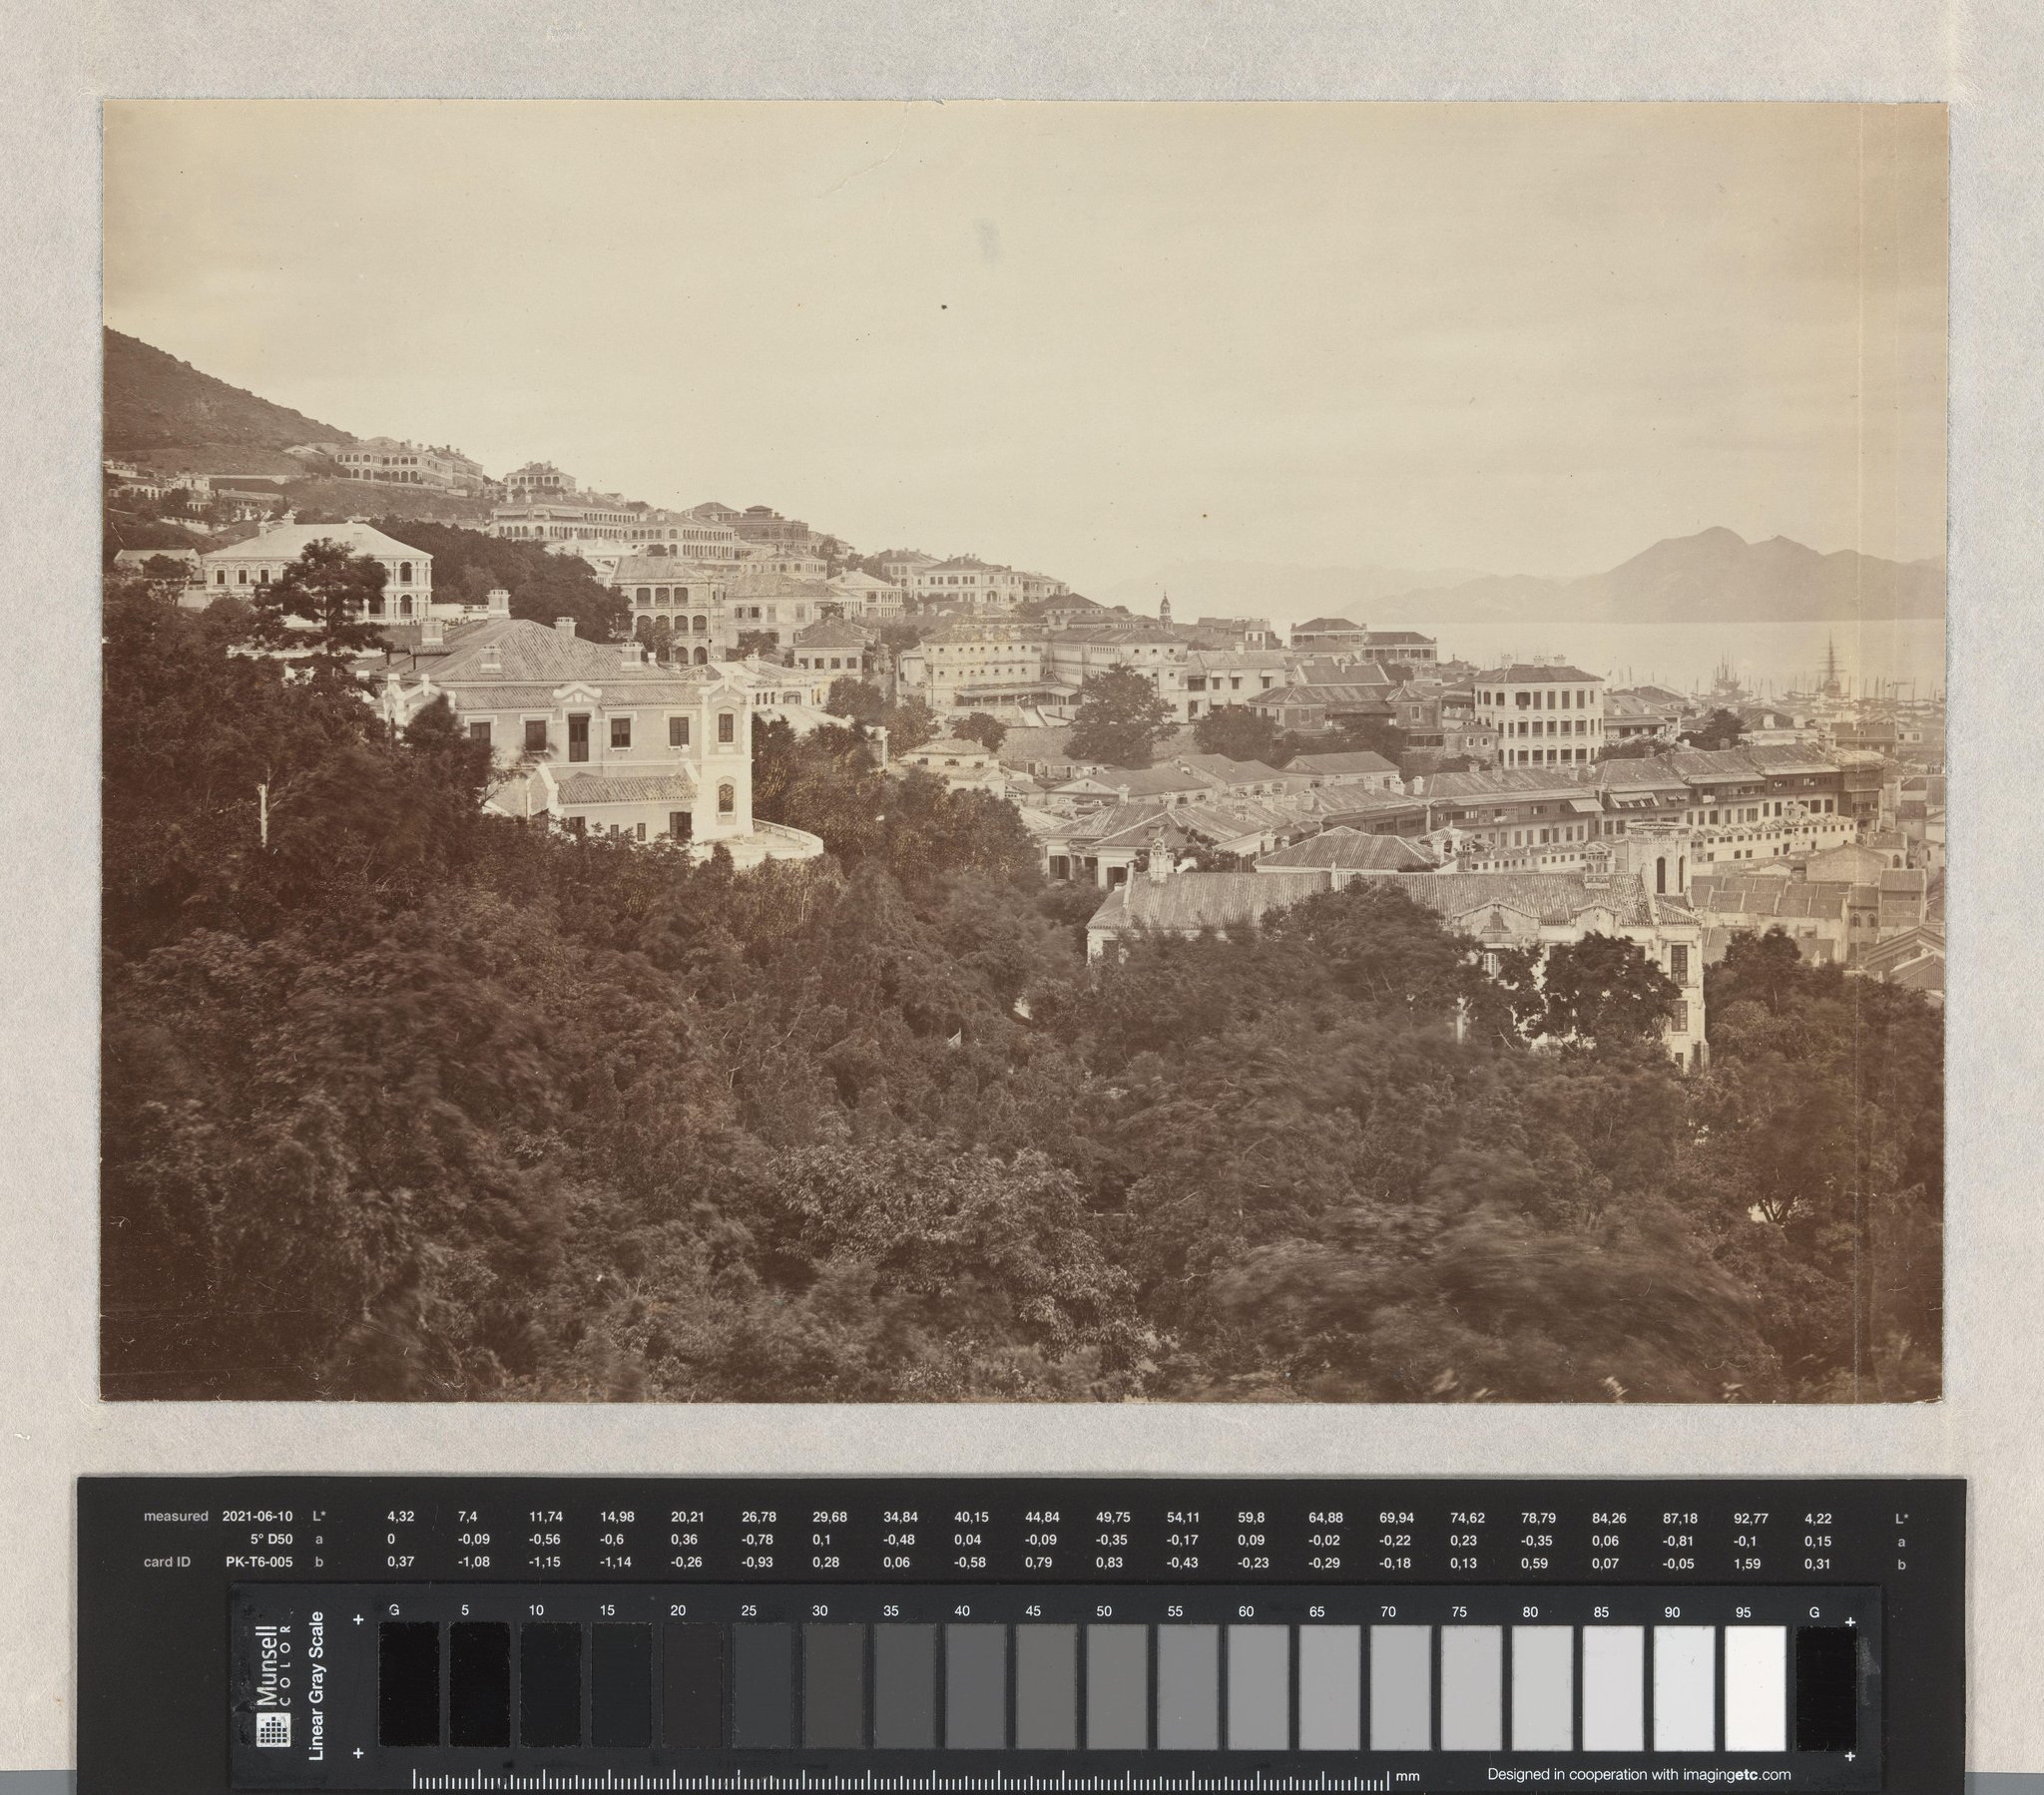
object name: photograph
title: View of Hong Kong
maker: Anonymous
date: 1865-1875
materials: paper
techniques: albumen print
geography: hong kong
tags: hong kong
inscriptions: signature: ‘A.J.B.’, number: ‘8’, inscription: ‘Hongkong’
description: Some photographs in the Bauduin collection have ‘A.J.B.’ written on the back. This suggests they belonged to Albert, whose full name was Albertus Johannes. Albert’s correspondence makes no mention of a stop in Hong Kong, but the initials suggest he visited this emerging city.